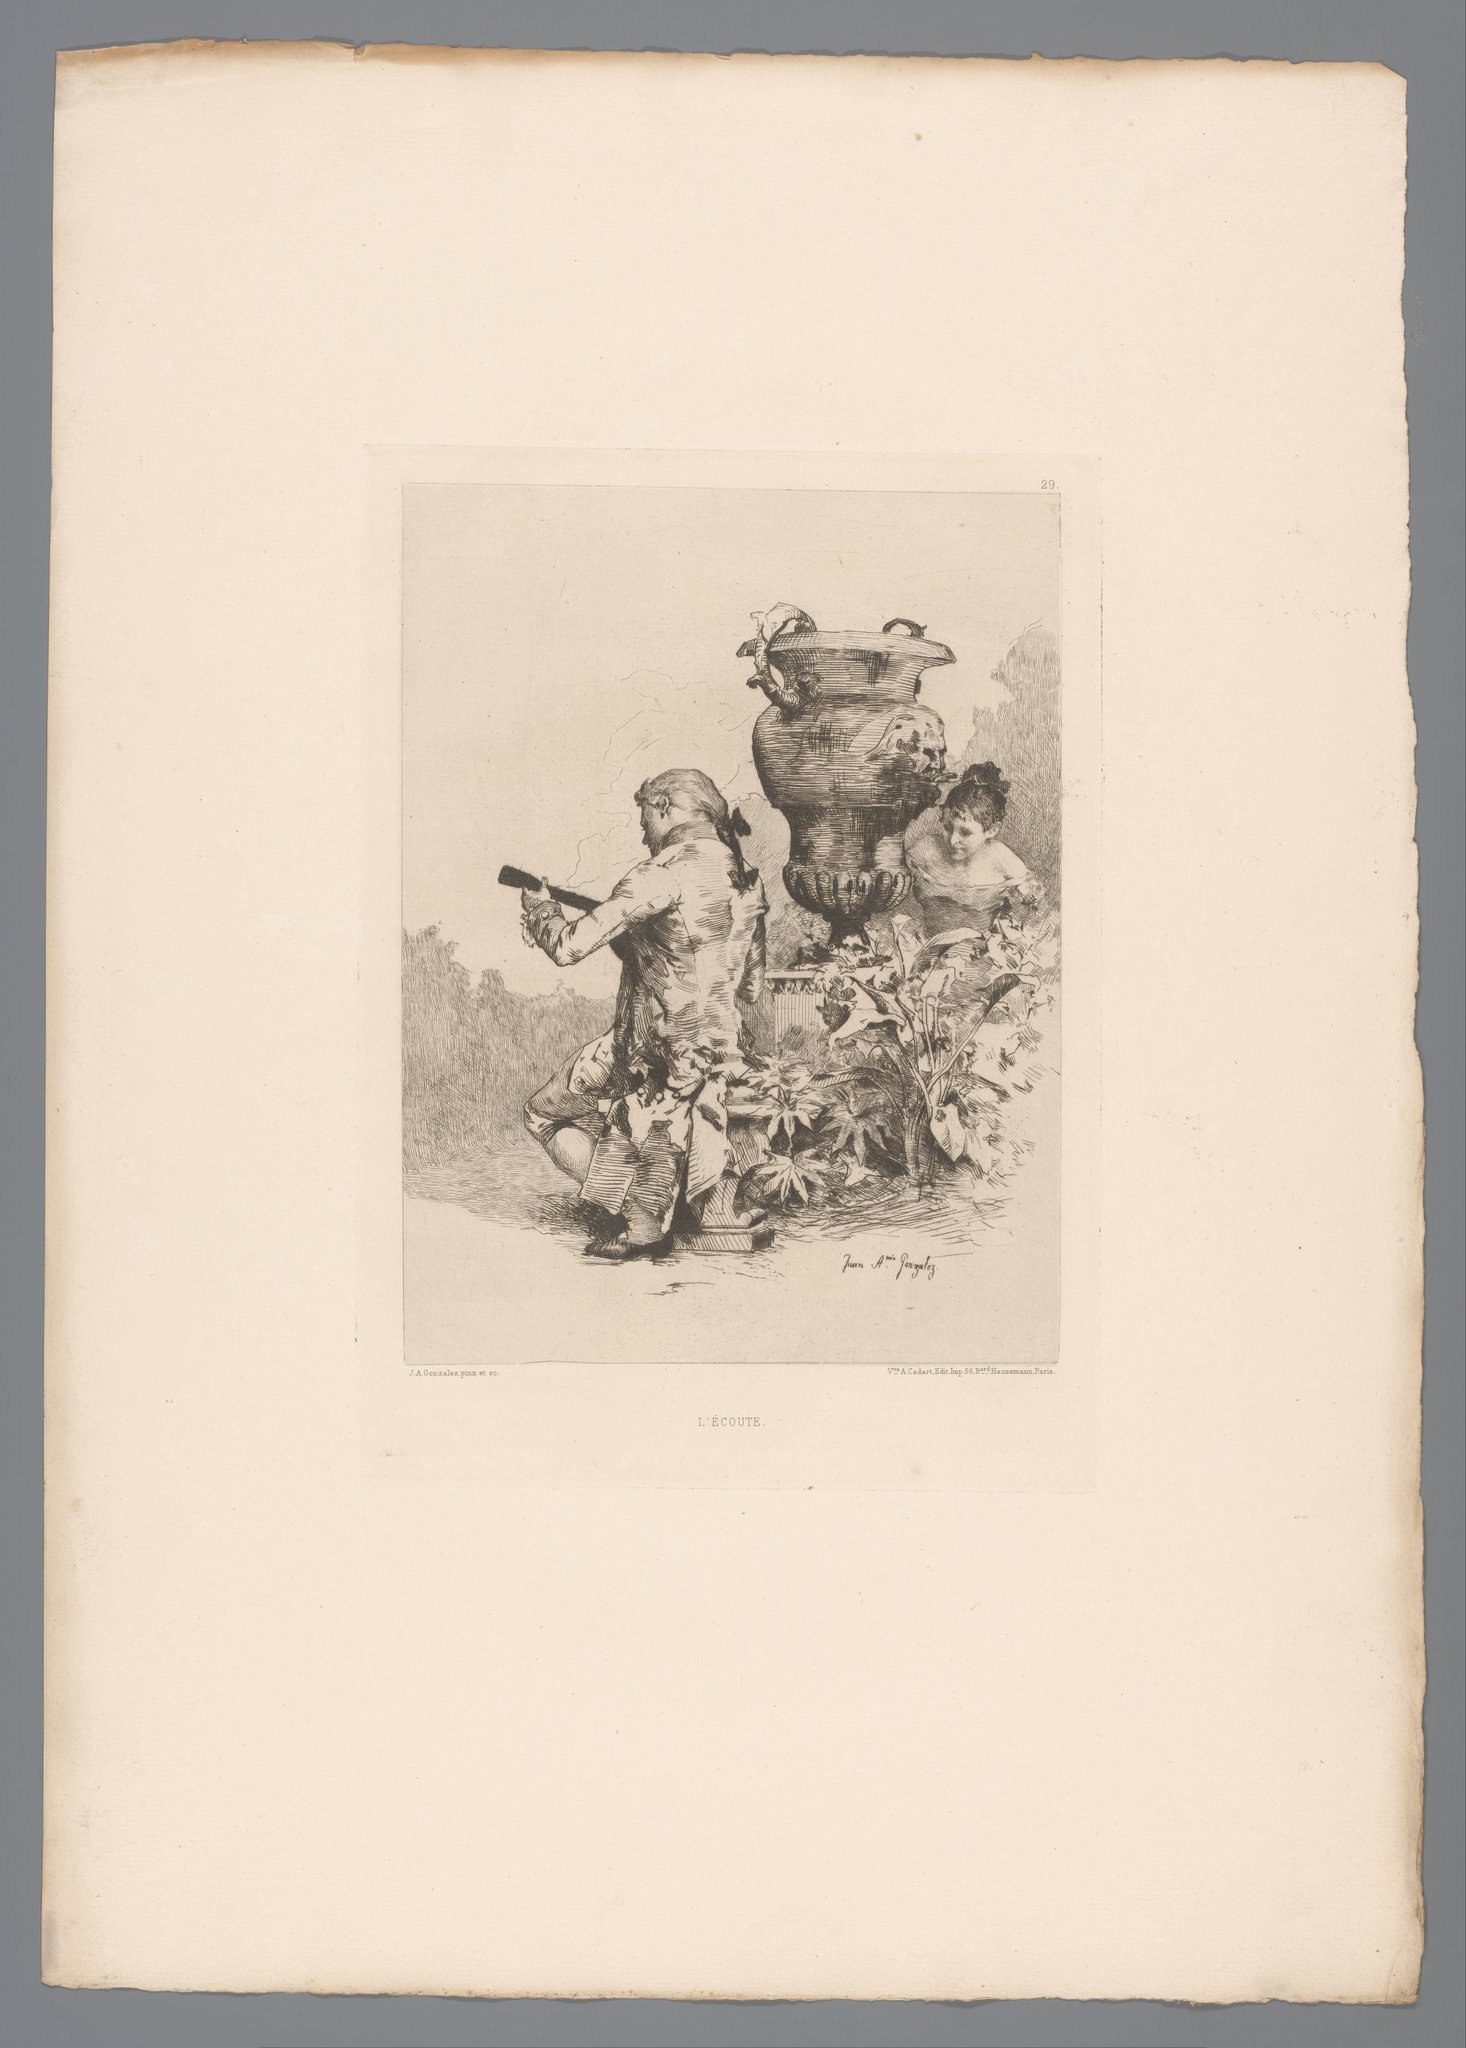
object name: print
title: Musicerende man op een tuinbank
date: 1878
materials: paper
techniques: drypoint, etching, intaglio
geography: paris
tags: listening to music - cc - out of doors, one person playing an instrument, garden vase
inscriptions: collector's mark: Lugt 2760, collector's mark: Lugt 2228, collector's mark: ‘AFE v S’, watermark